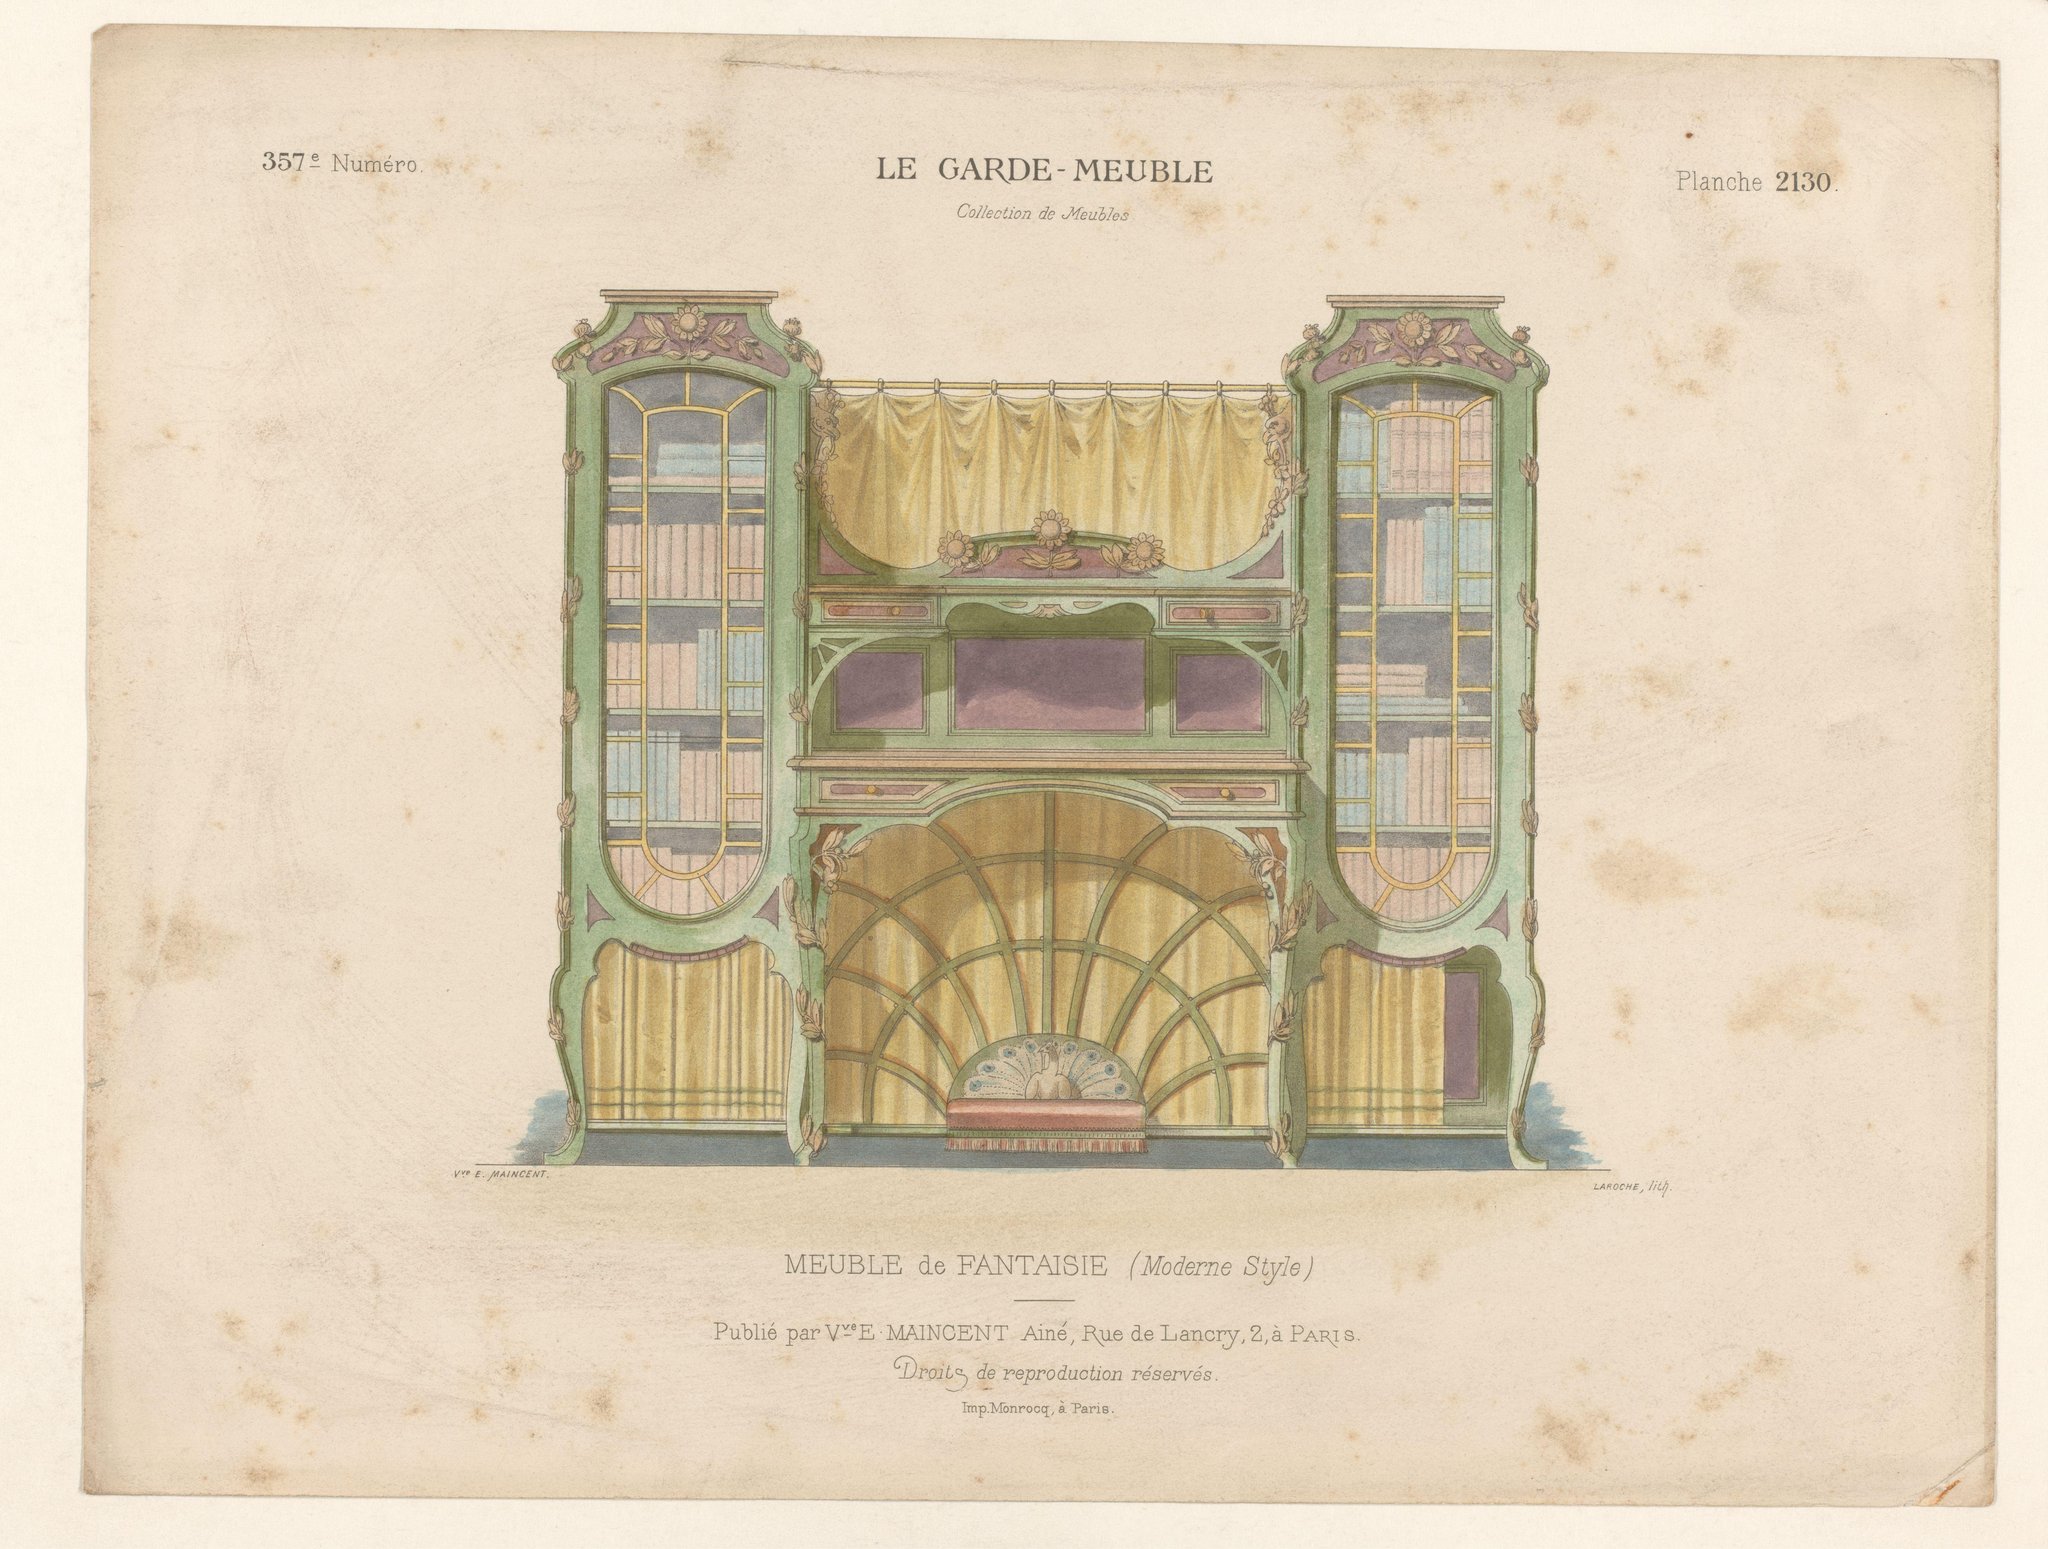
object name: print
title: Le garde-meuble / Collection de Meubles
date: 1895-1935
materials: paper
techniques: hand coloring, lithograph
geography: paris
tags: writing-table, writing-desk, bookcase, with doors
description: Ieder Livraison in de serie Le Garde-Meuble bevat negen platen: drie 'sièges' (zitmeubels), drie 'meubles' (diverse meubels zoals tafels en kasten) en drie 'tentures' (gordijnen en draperieën).